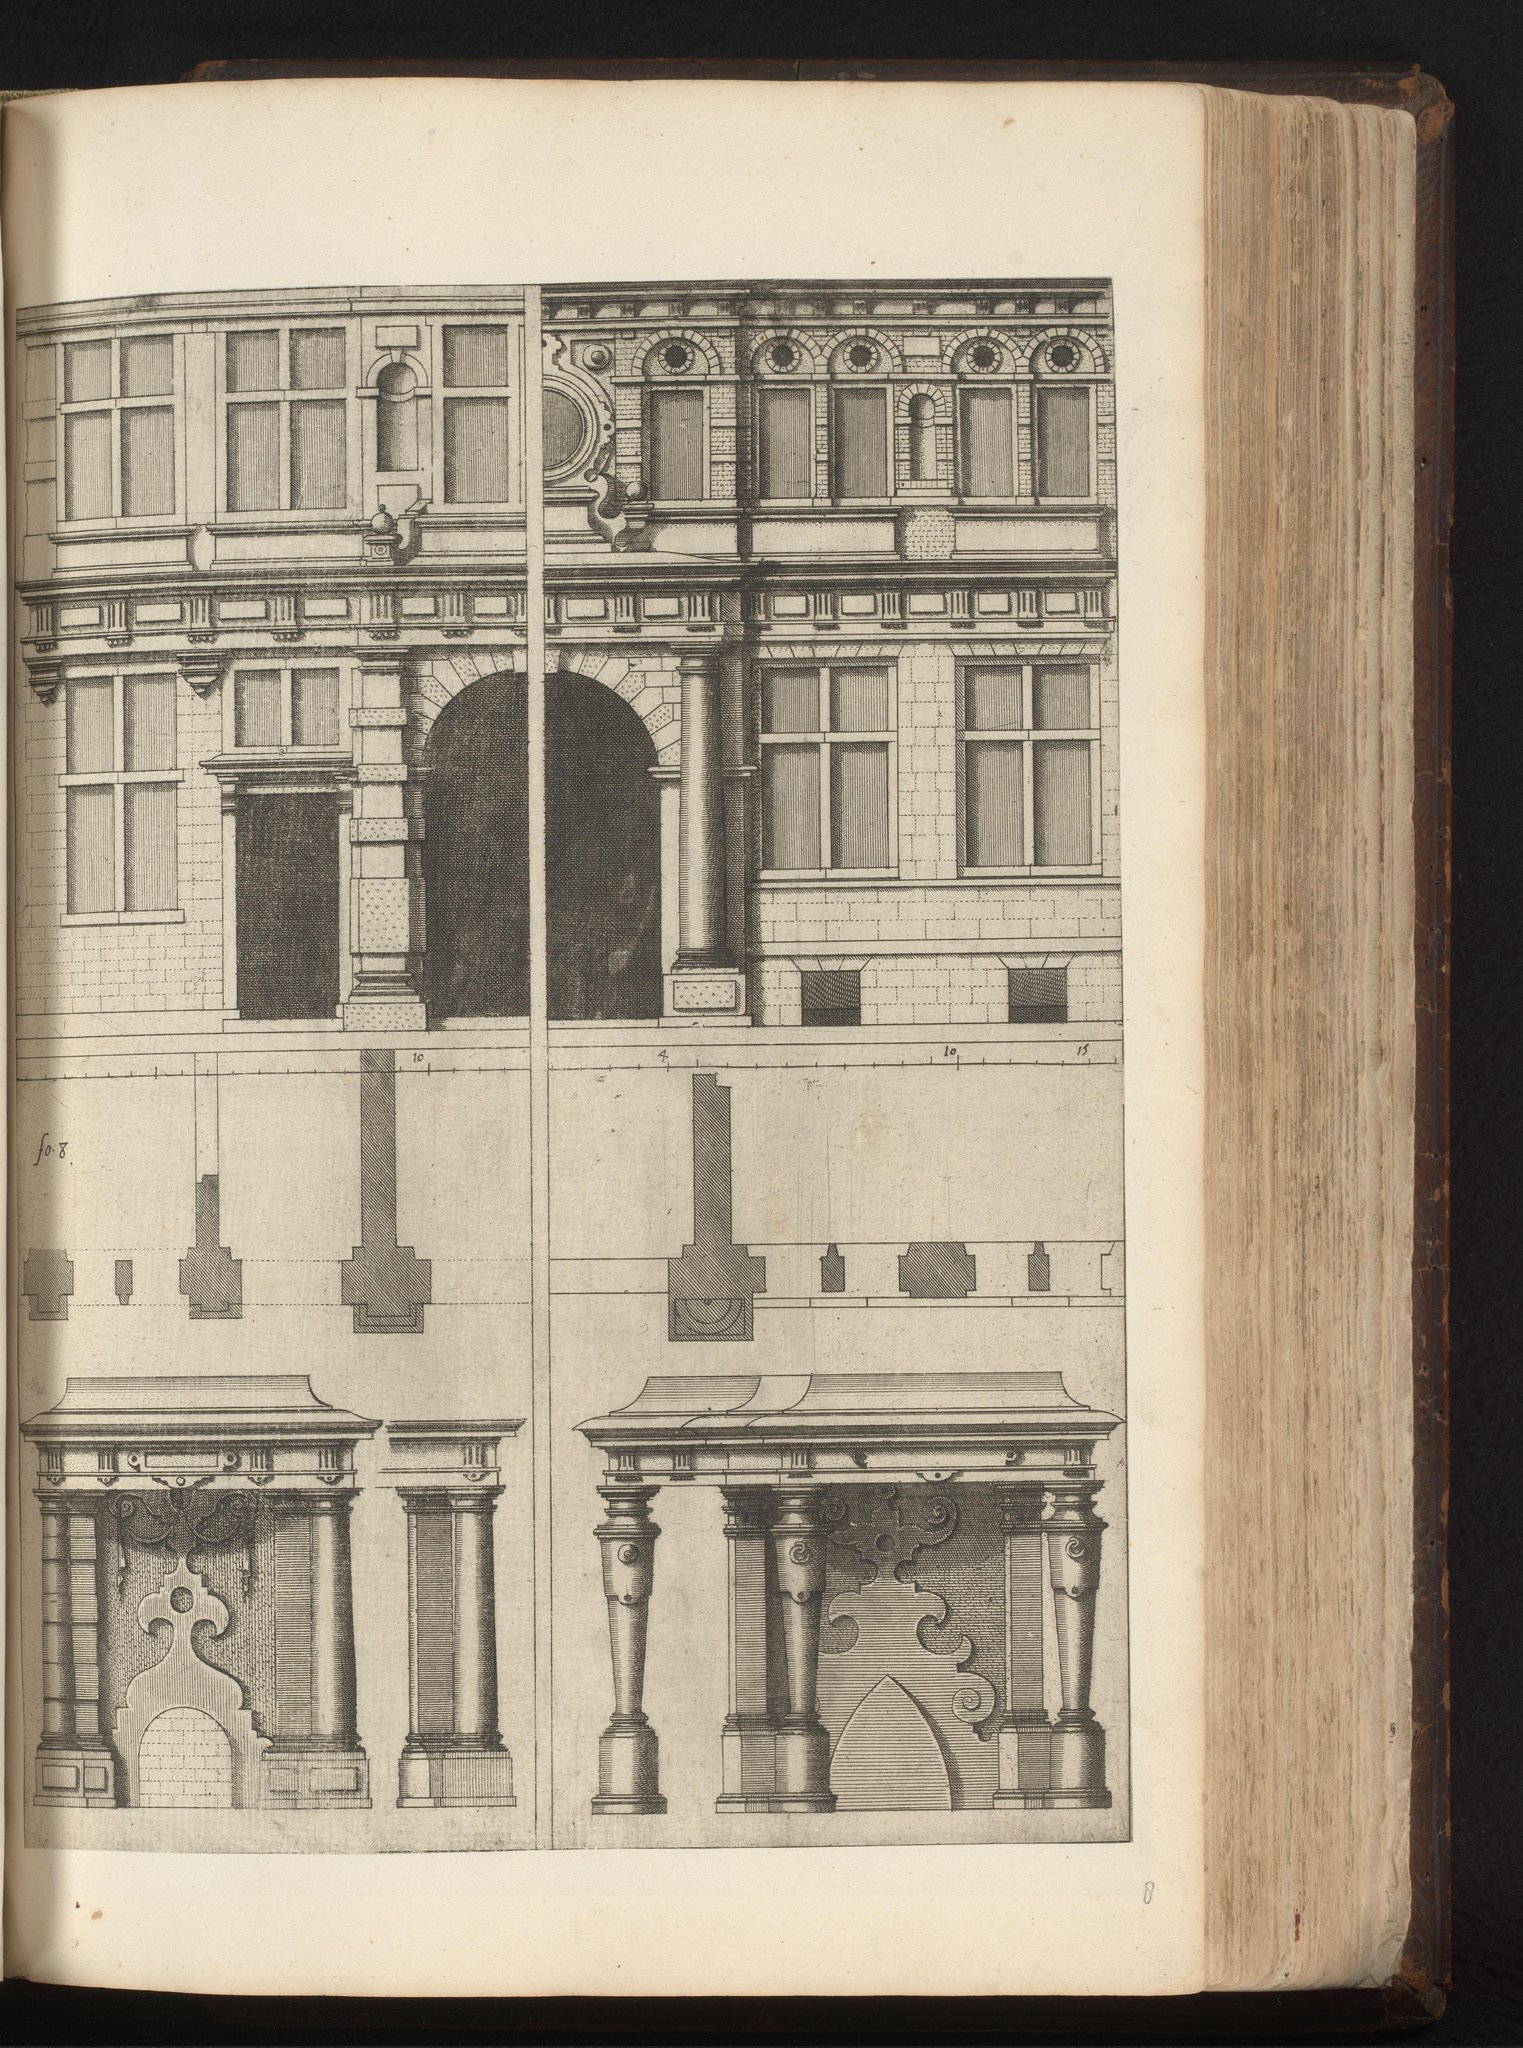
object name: book illustration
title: Gevels en haarden in de Dorische orde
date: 1581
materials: paper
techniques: engraving, etching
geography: antwerp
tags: doric order ~ architecture, open hearth, fire-place, civic architecture; edifices; dwellings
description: Prent uit: Vredeman de Vries, Hans. Architectura oder Bauung der Antiquen auss dem Vitruvius, waellches sein funff Collummen orden, (...). Antwerpen: Gerard de Jode en Gerard Smits, 1581. Prent eerder verschenen in de 1577-editie.